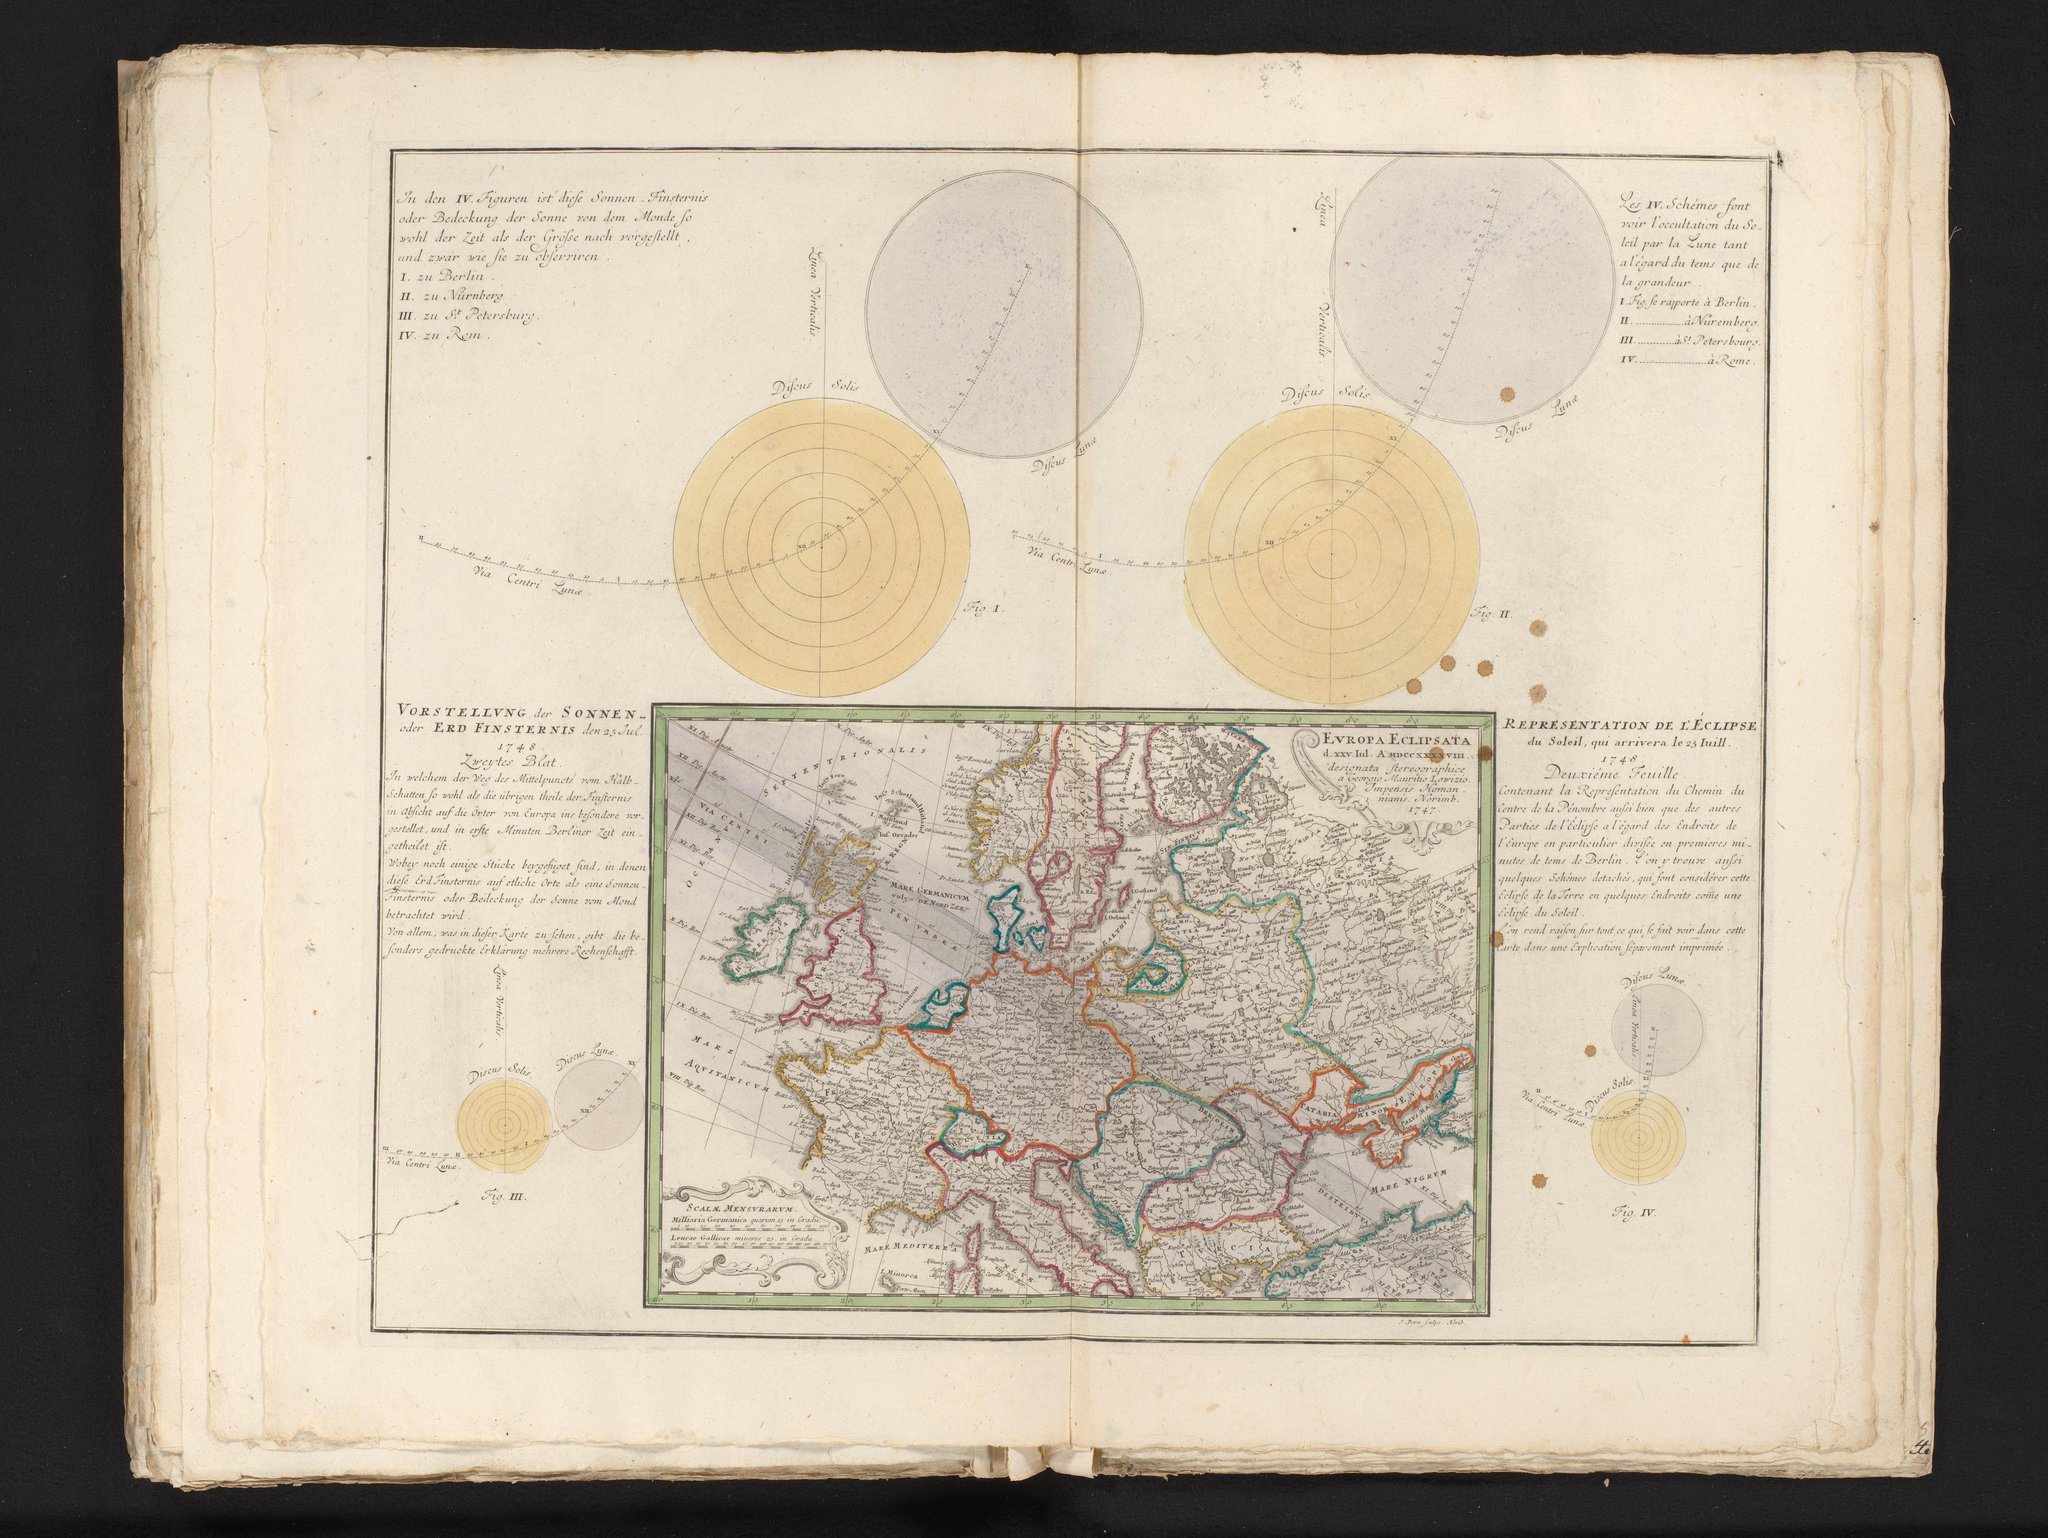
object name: print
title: Vorstellung der Sonnen oder Erd Finsternis den 25 jul. 1748 / Representation de l'eclipse du soleil, qui arrivera le 25 Iuill. 1748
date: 1747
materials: paper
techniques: engraving, etching, hand coloring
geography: nuremberg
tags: solar eclipse